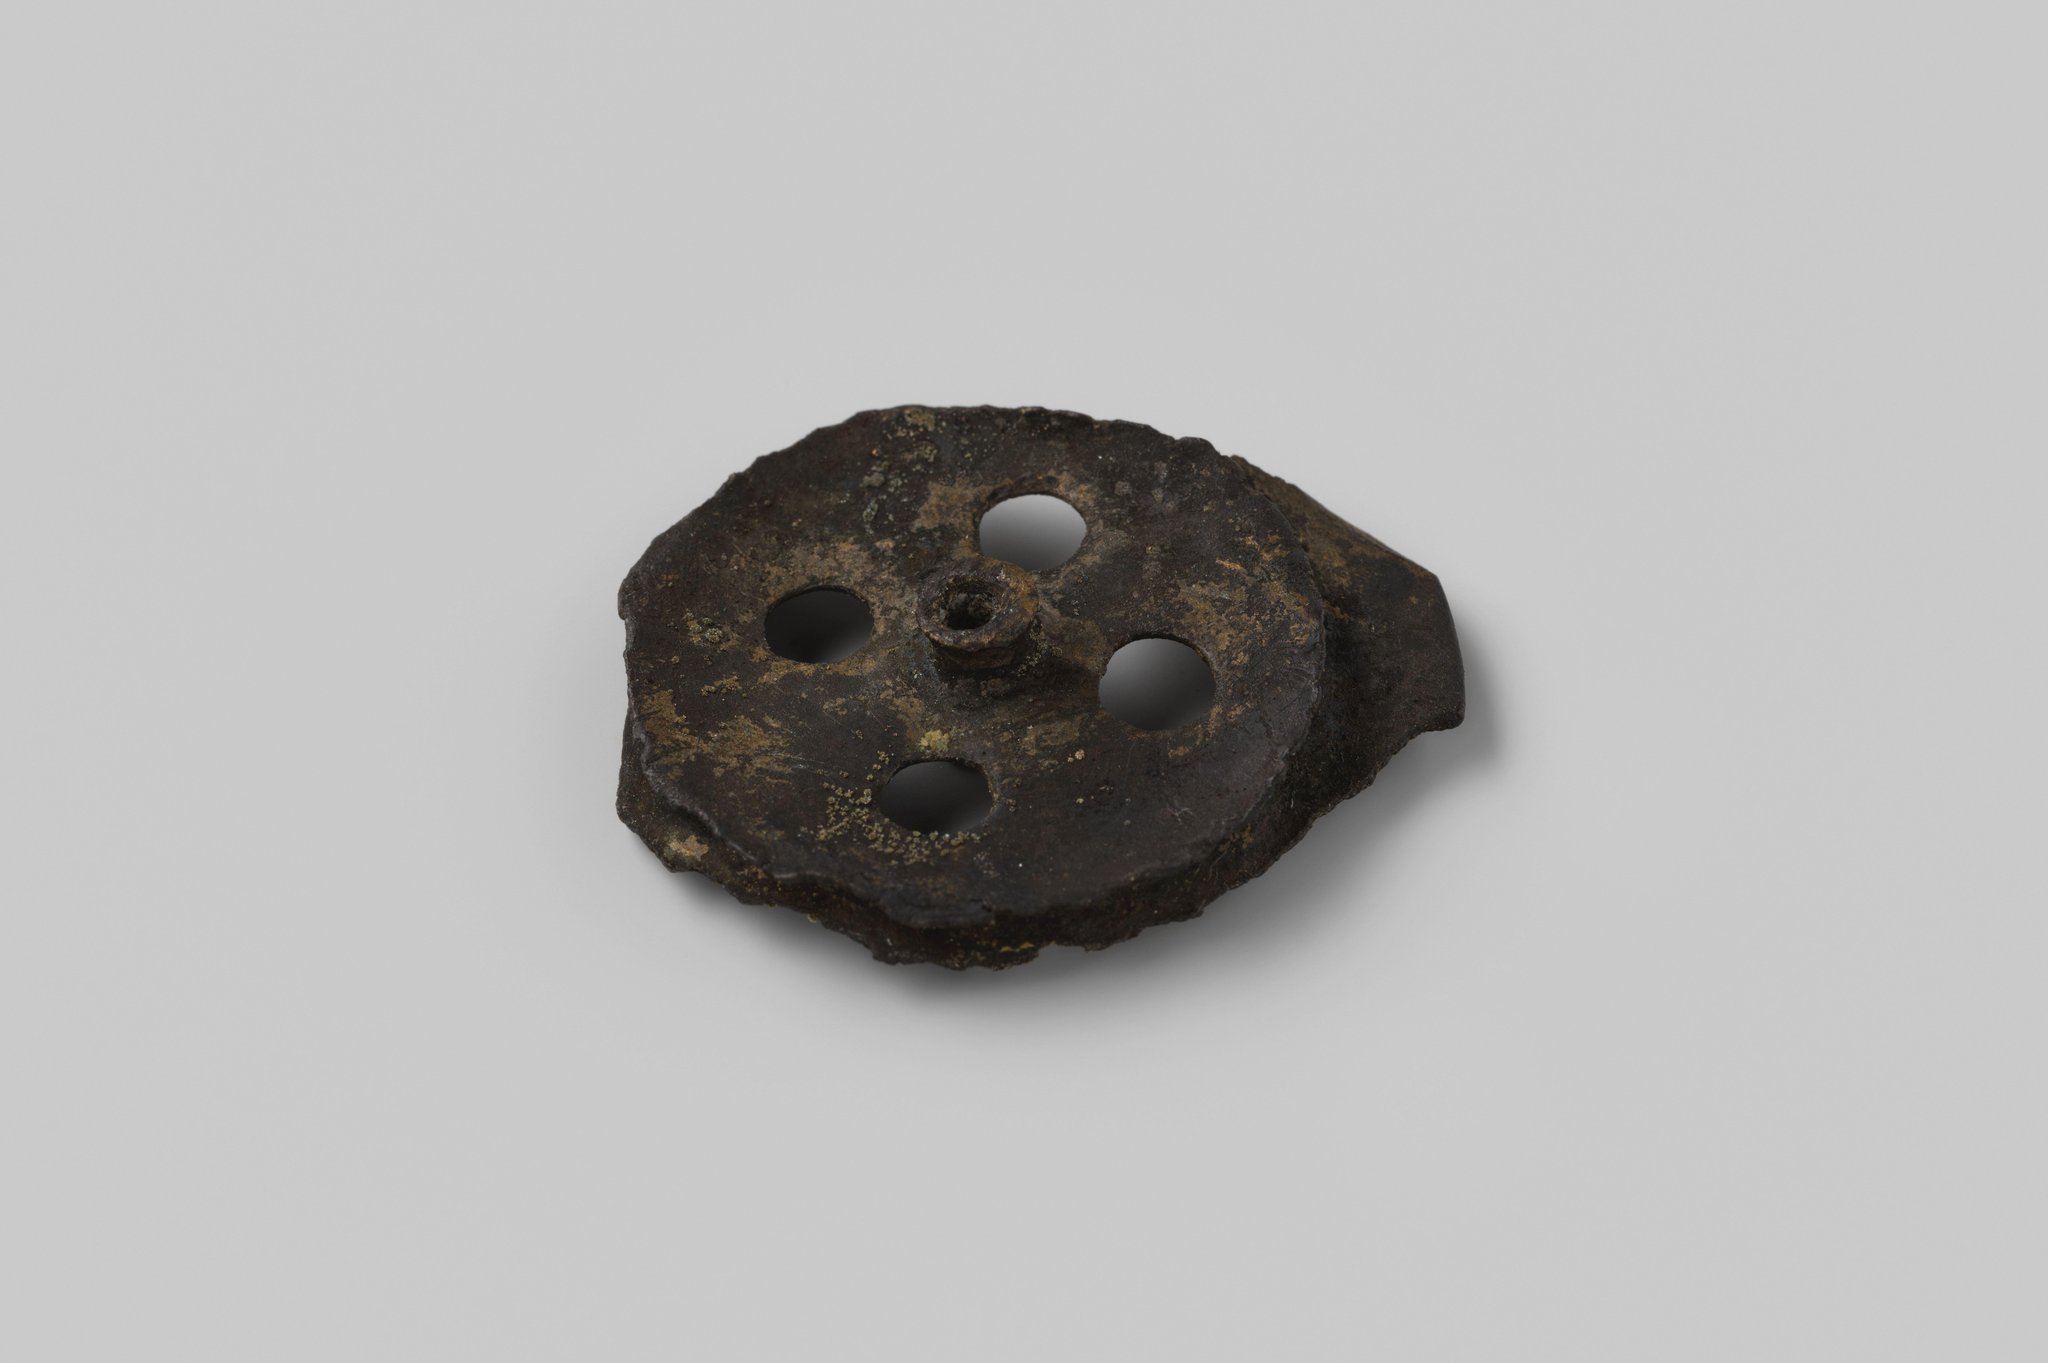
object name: part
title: Mechanisch onderdeel uit het wrak van de Oost-Indiëvaarder Hollandia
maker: Anonymous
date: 1700-1743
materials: copper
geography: netherlands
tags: verenigde oostindische compagnie, hollandia (schip), annet